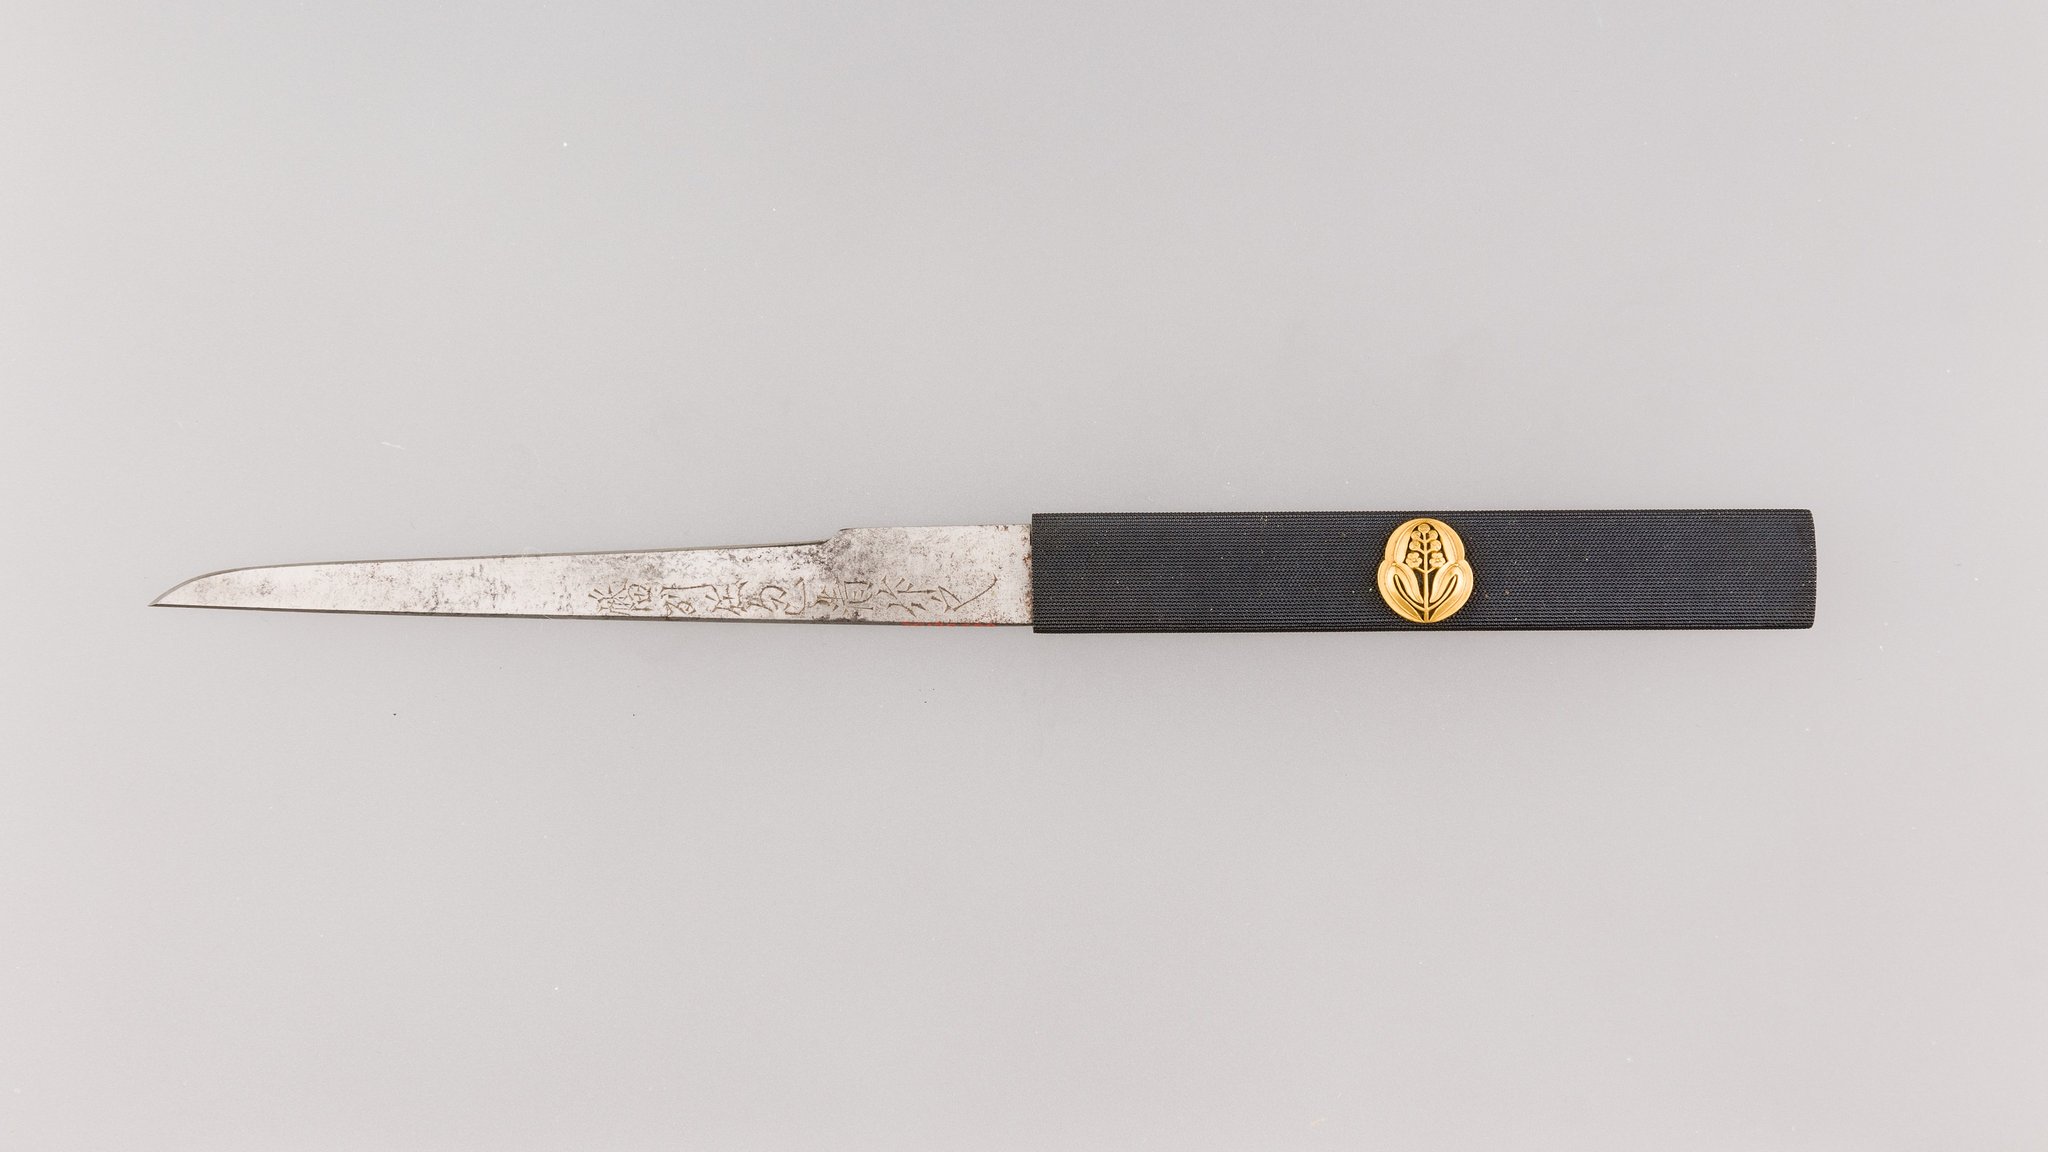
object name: knife handle kozuka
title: Knife Handle (Kozuka) with Blade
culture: japanese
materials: gold alloy, gold, steel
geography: japan